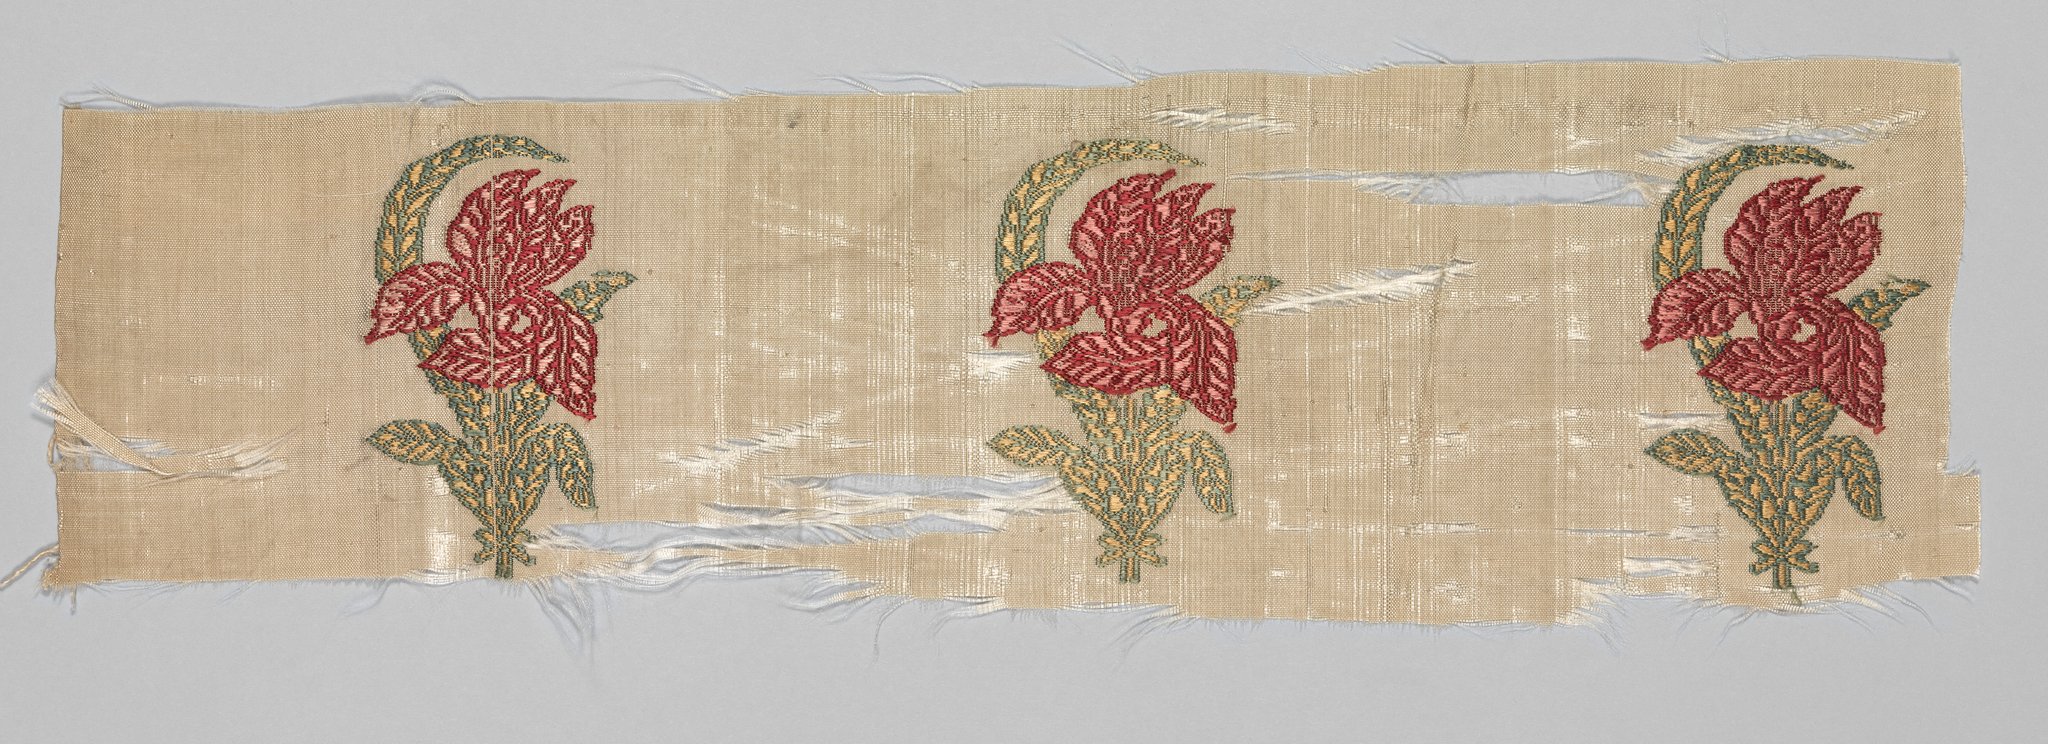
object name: textile fragment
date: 1700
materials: metal thread, silk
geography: india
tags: flowers